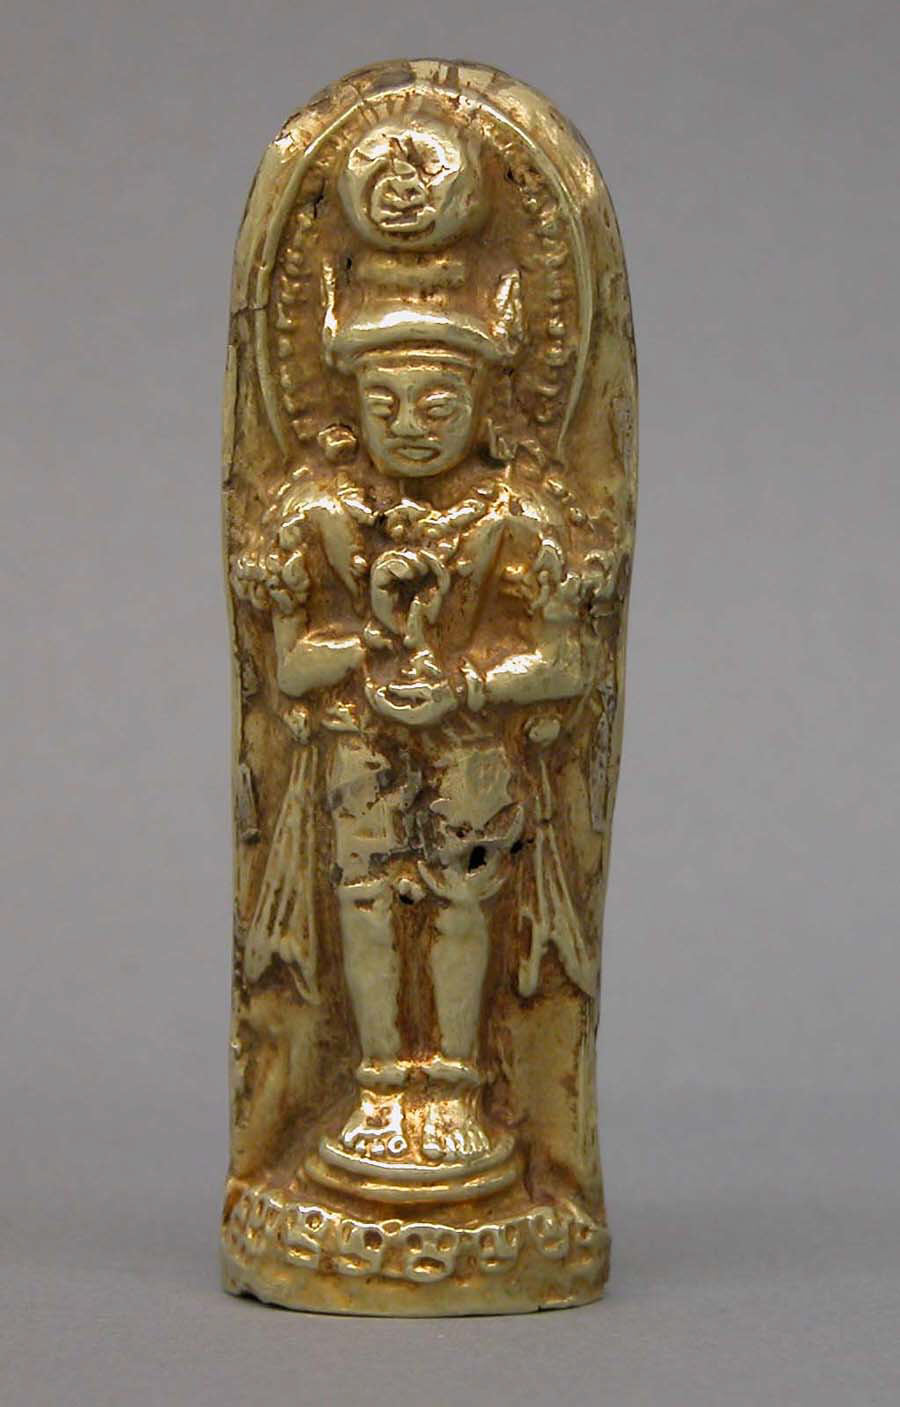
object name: figure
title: Sculpture of Bhairava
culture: indonesian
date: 1201-1400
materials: gold